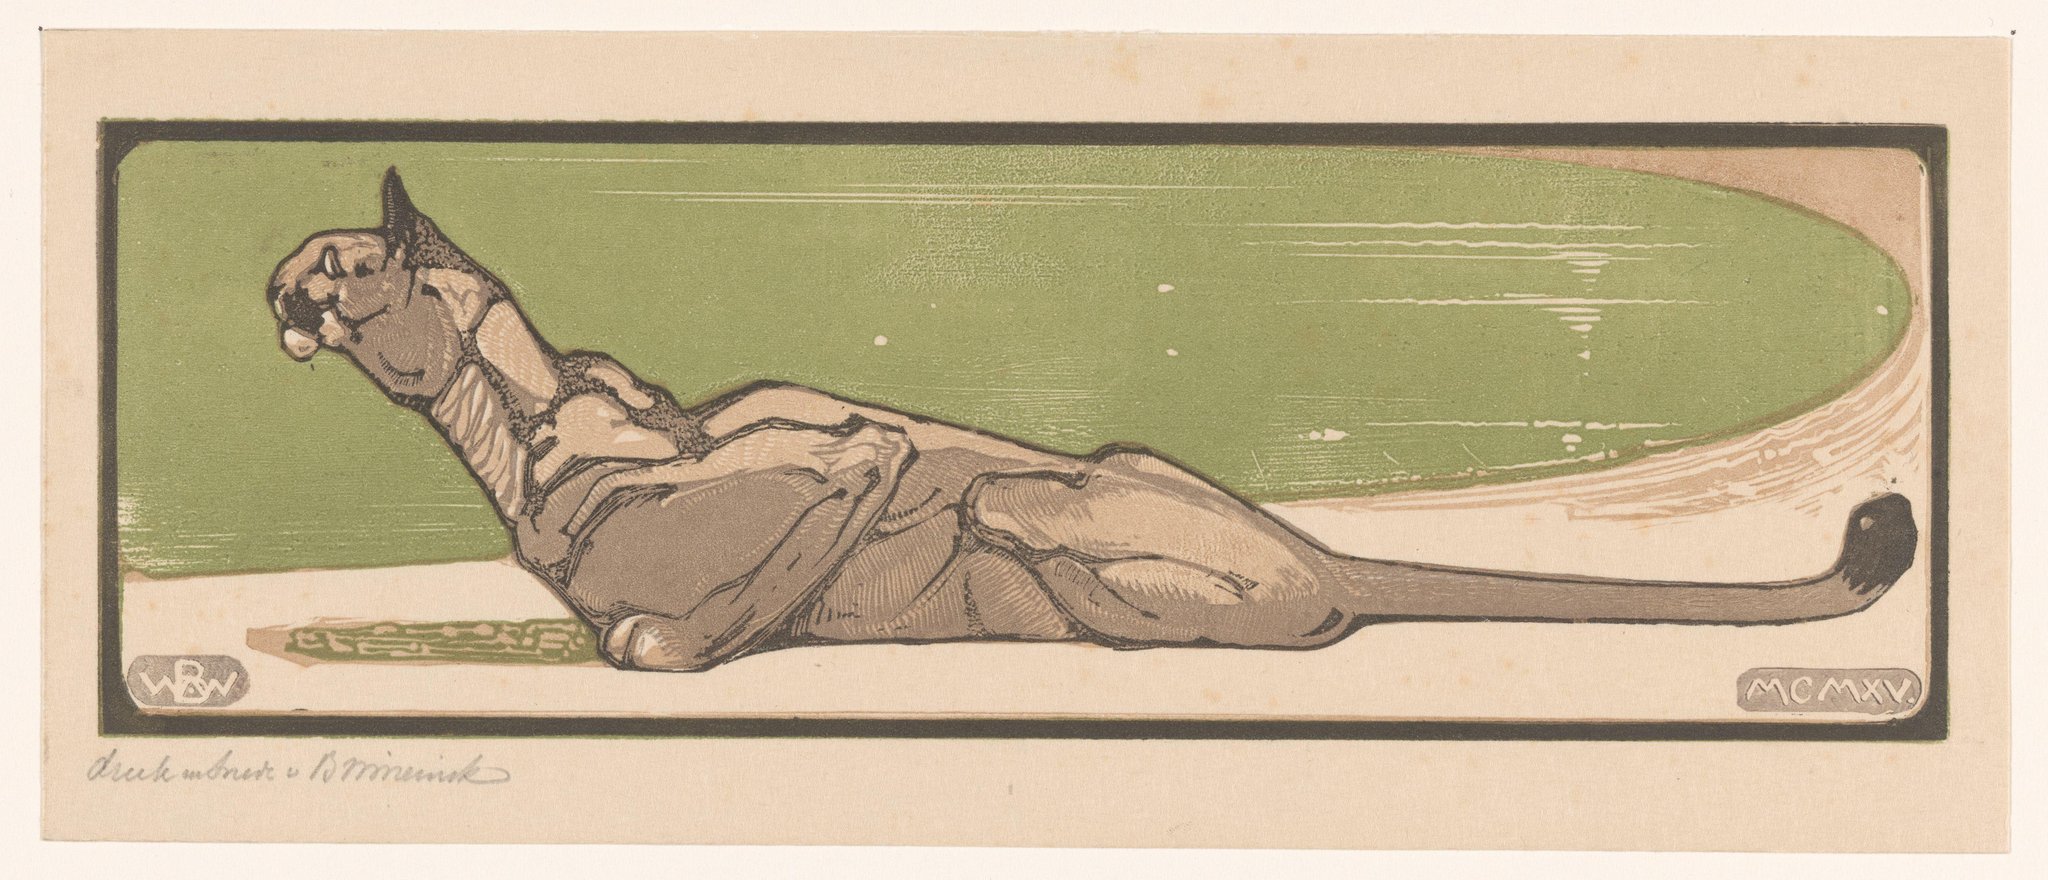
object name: print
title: Puma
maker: bernard willem wierink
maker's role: draughtsman, print maker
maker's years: 1856-1939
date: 1915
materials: paper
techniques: relief print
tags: beasts of prey, predatory animals: puma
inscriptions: collector's mark: Lugt 2228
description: Deze prent is vermoedelijk een plaatsnede, ook al wordt in de literatuur veelal gesproken over een houtsnede. Voor zover Wierink zijn prenten in hoogdruk zelf nader heeft omschreven, heeft hij altijd de term 'plaatsnede' gebruikt.